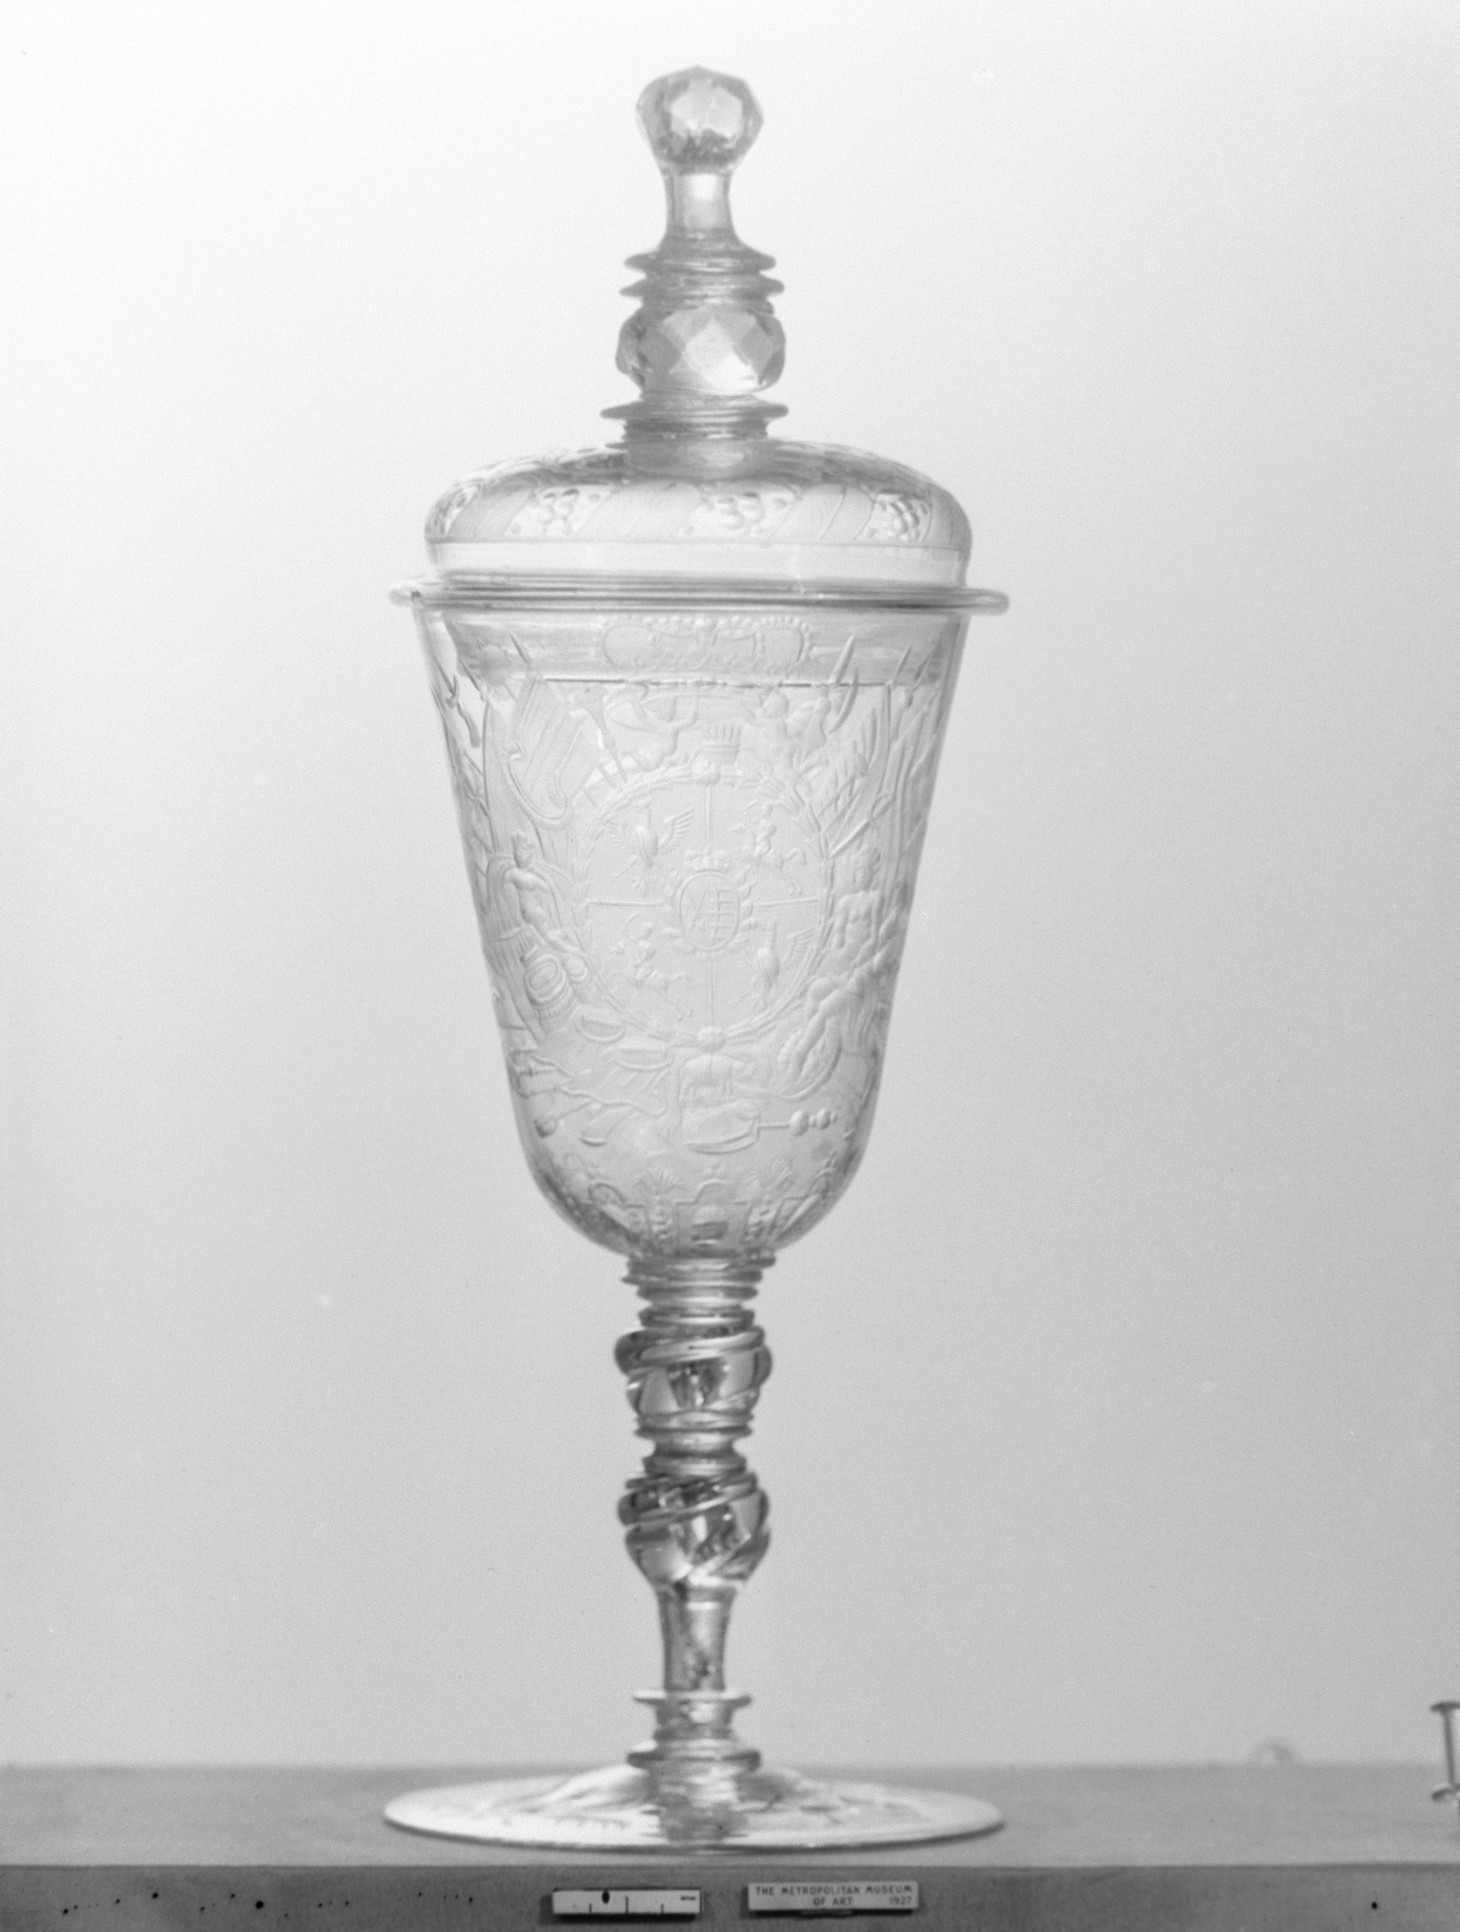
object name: standing cup with cover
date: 1710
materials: glass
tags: birds,female nudes,horses,coat of arms